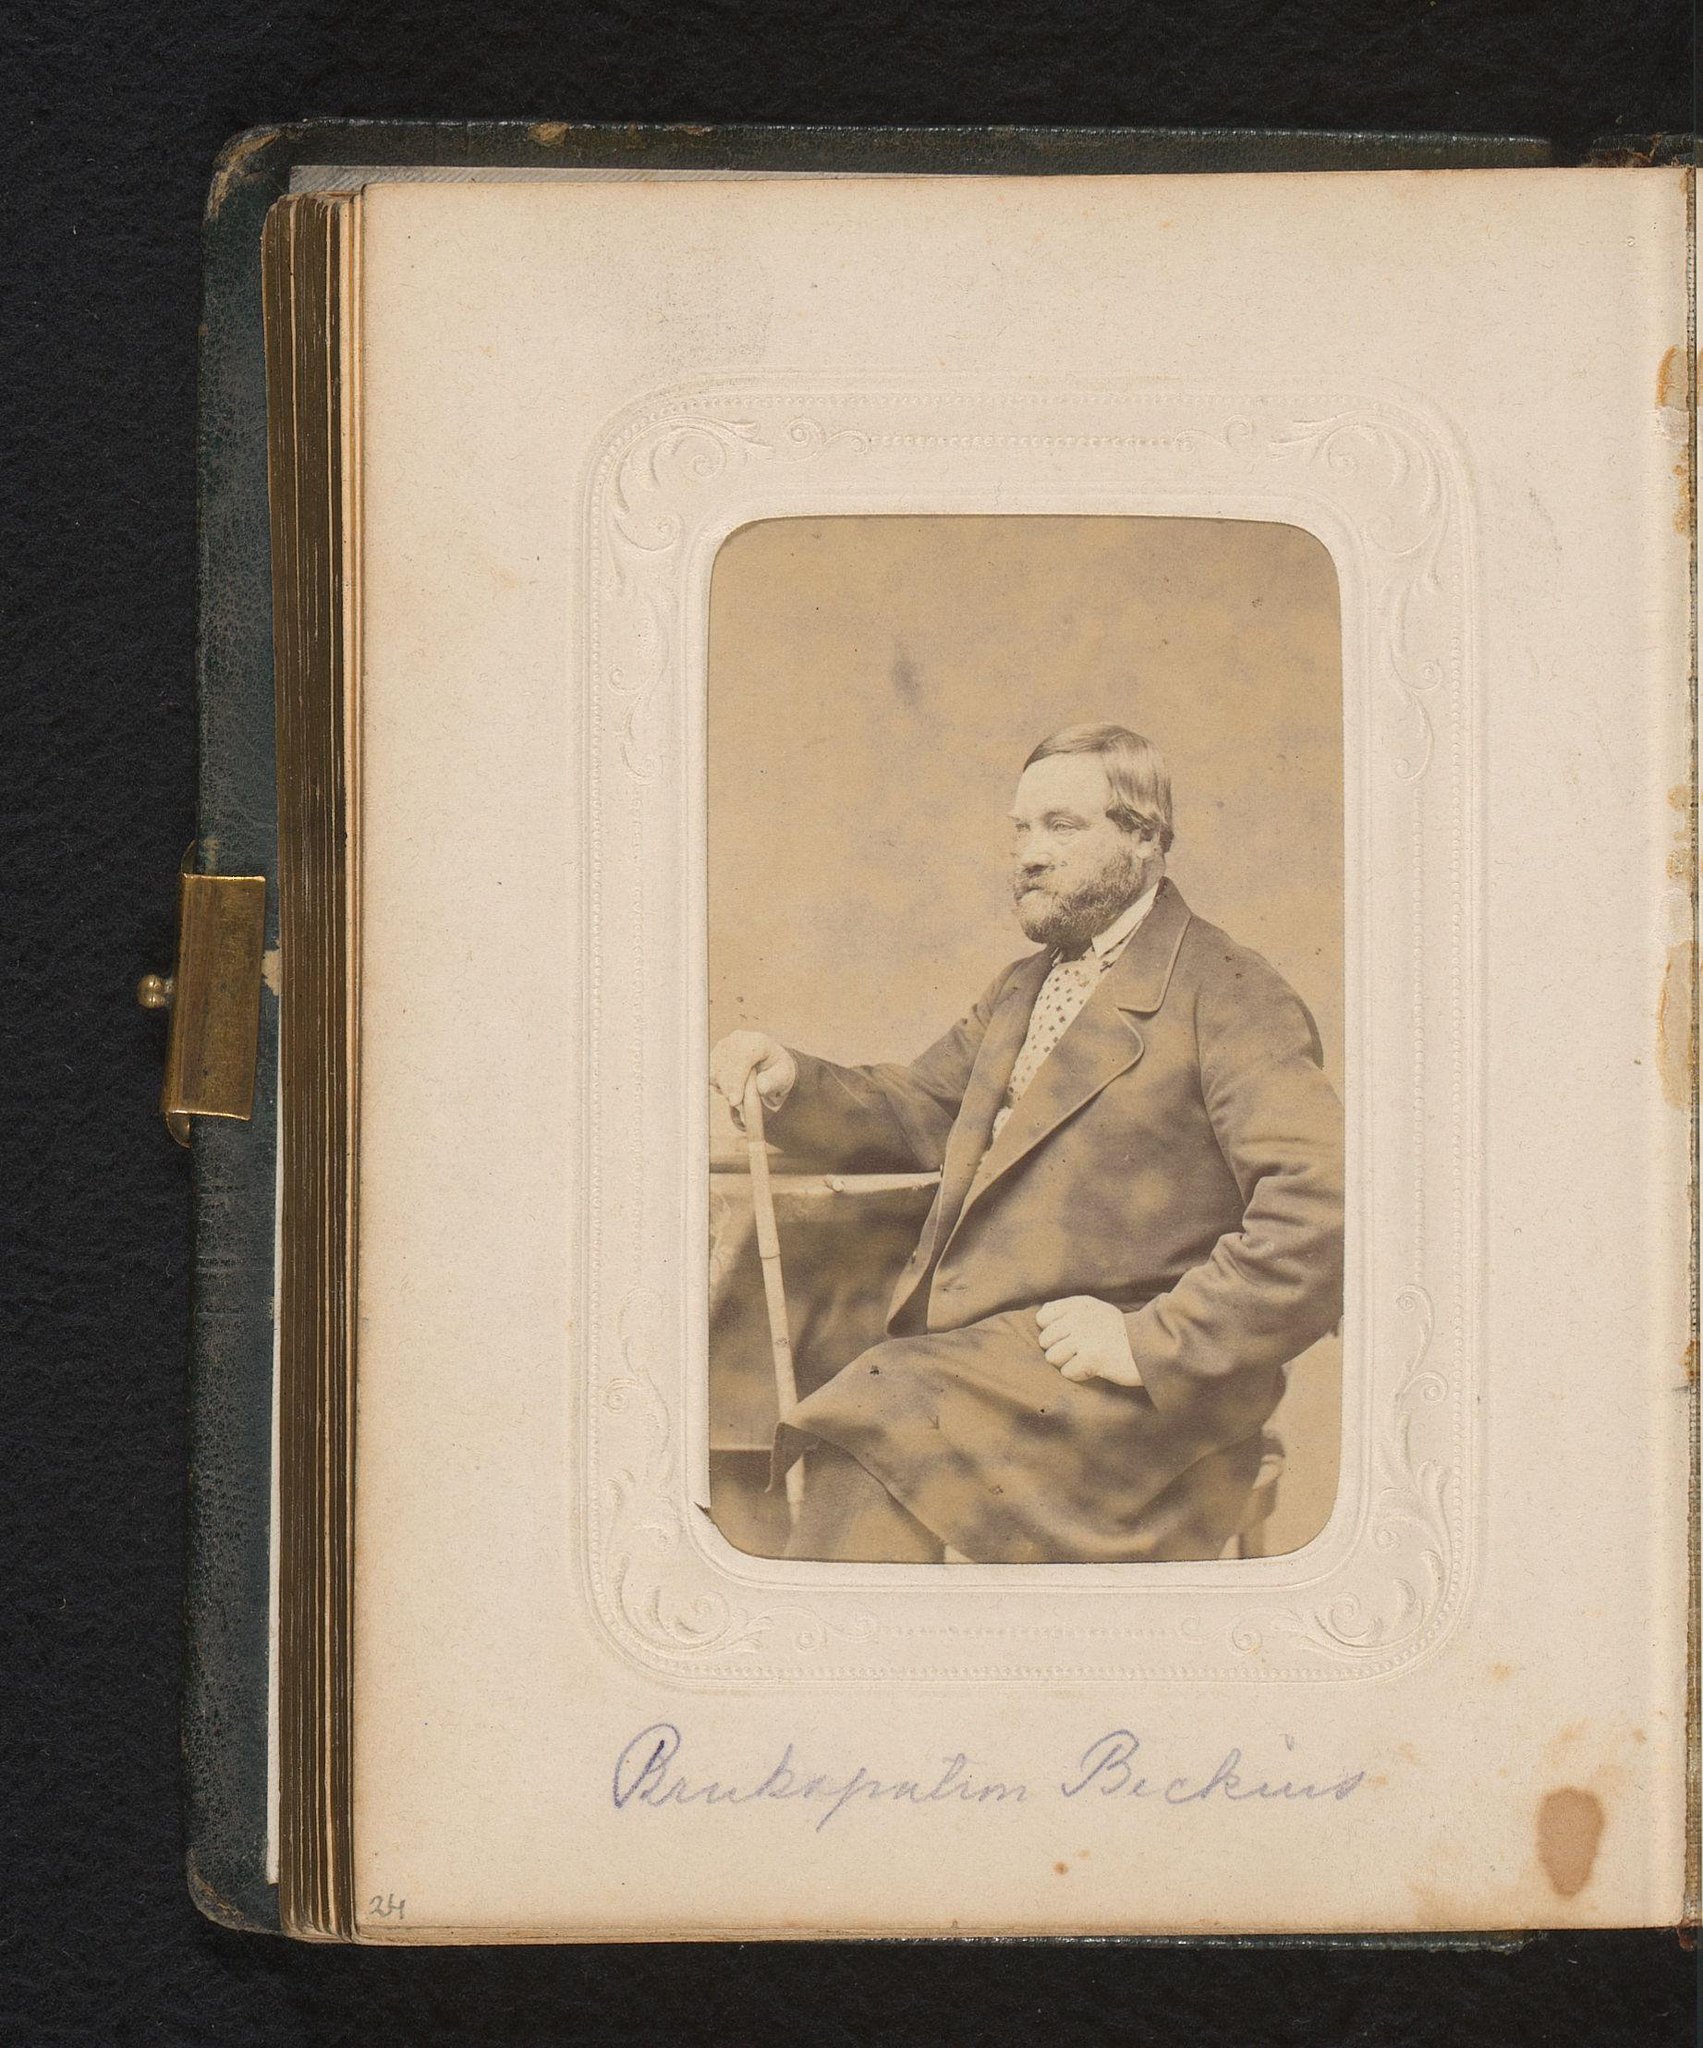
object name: album leaf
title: Portret van een zittende man met wandelstok, aangeduid als Beckius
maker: f. lamm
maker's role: fotograaf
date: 1860-1900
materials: cardboard, photographic support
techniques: albumen print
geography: stockholm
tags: sitting figure, walking-stick, staff, historical persons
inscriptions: name: ‘Brukspatron Beckius’, annotation: ‘Brukspatron/ Beckius./ död’, inscription: ‘F. Lamm's/ Fotografiska Atelier/ Stockholm/ Drottninggatan No 15’